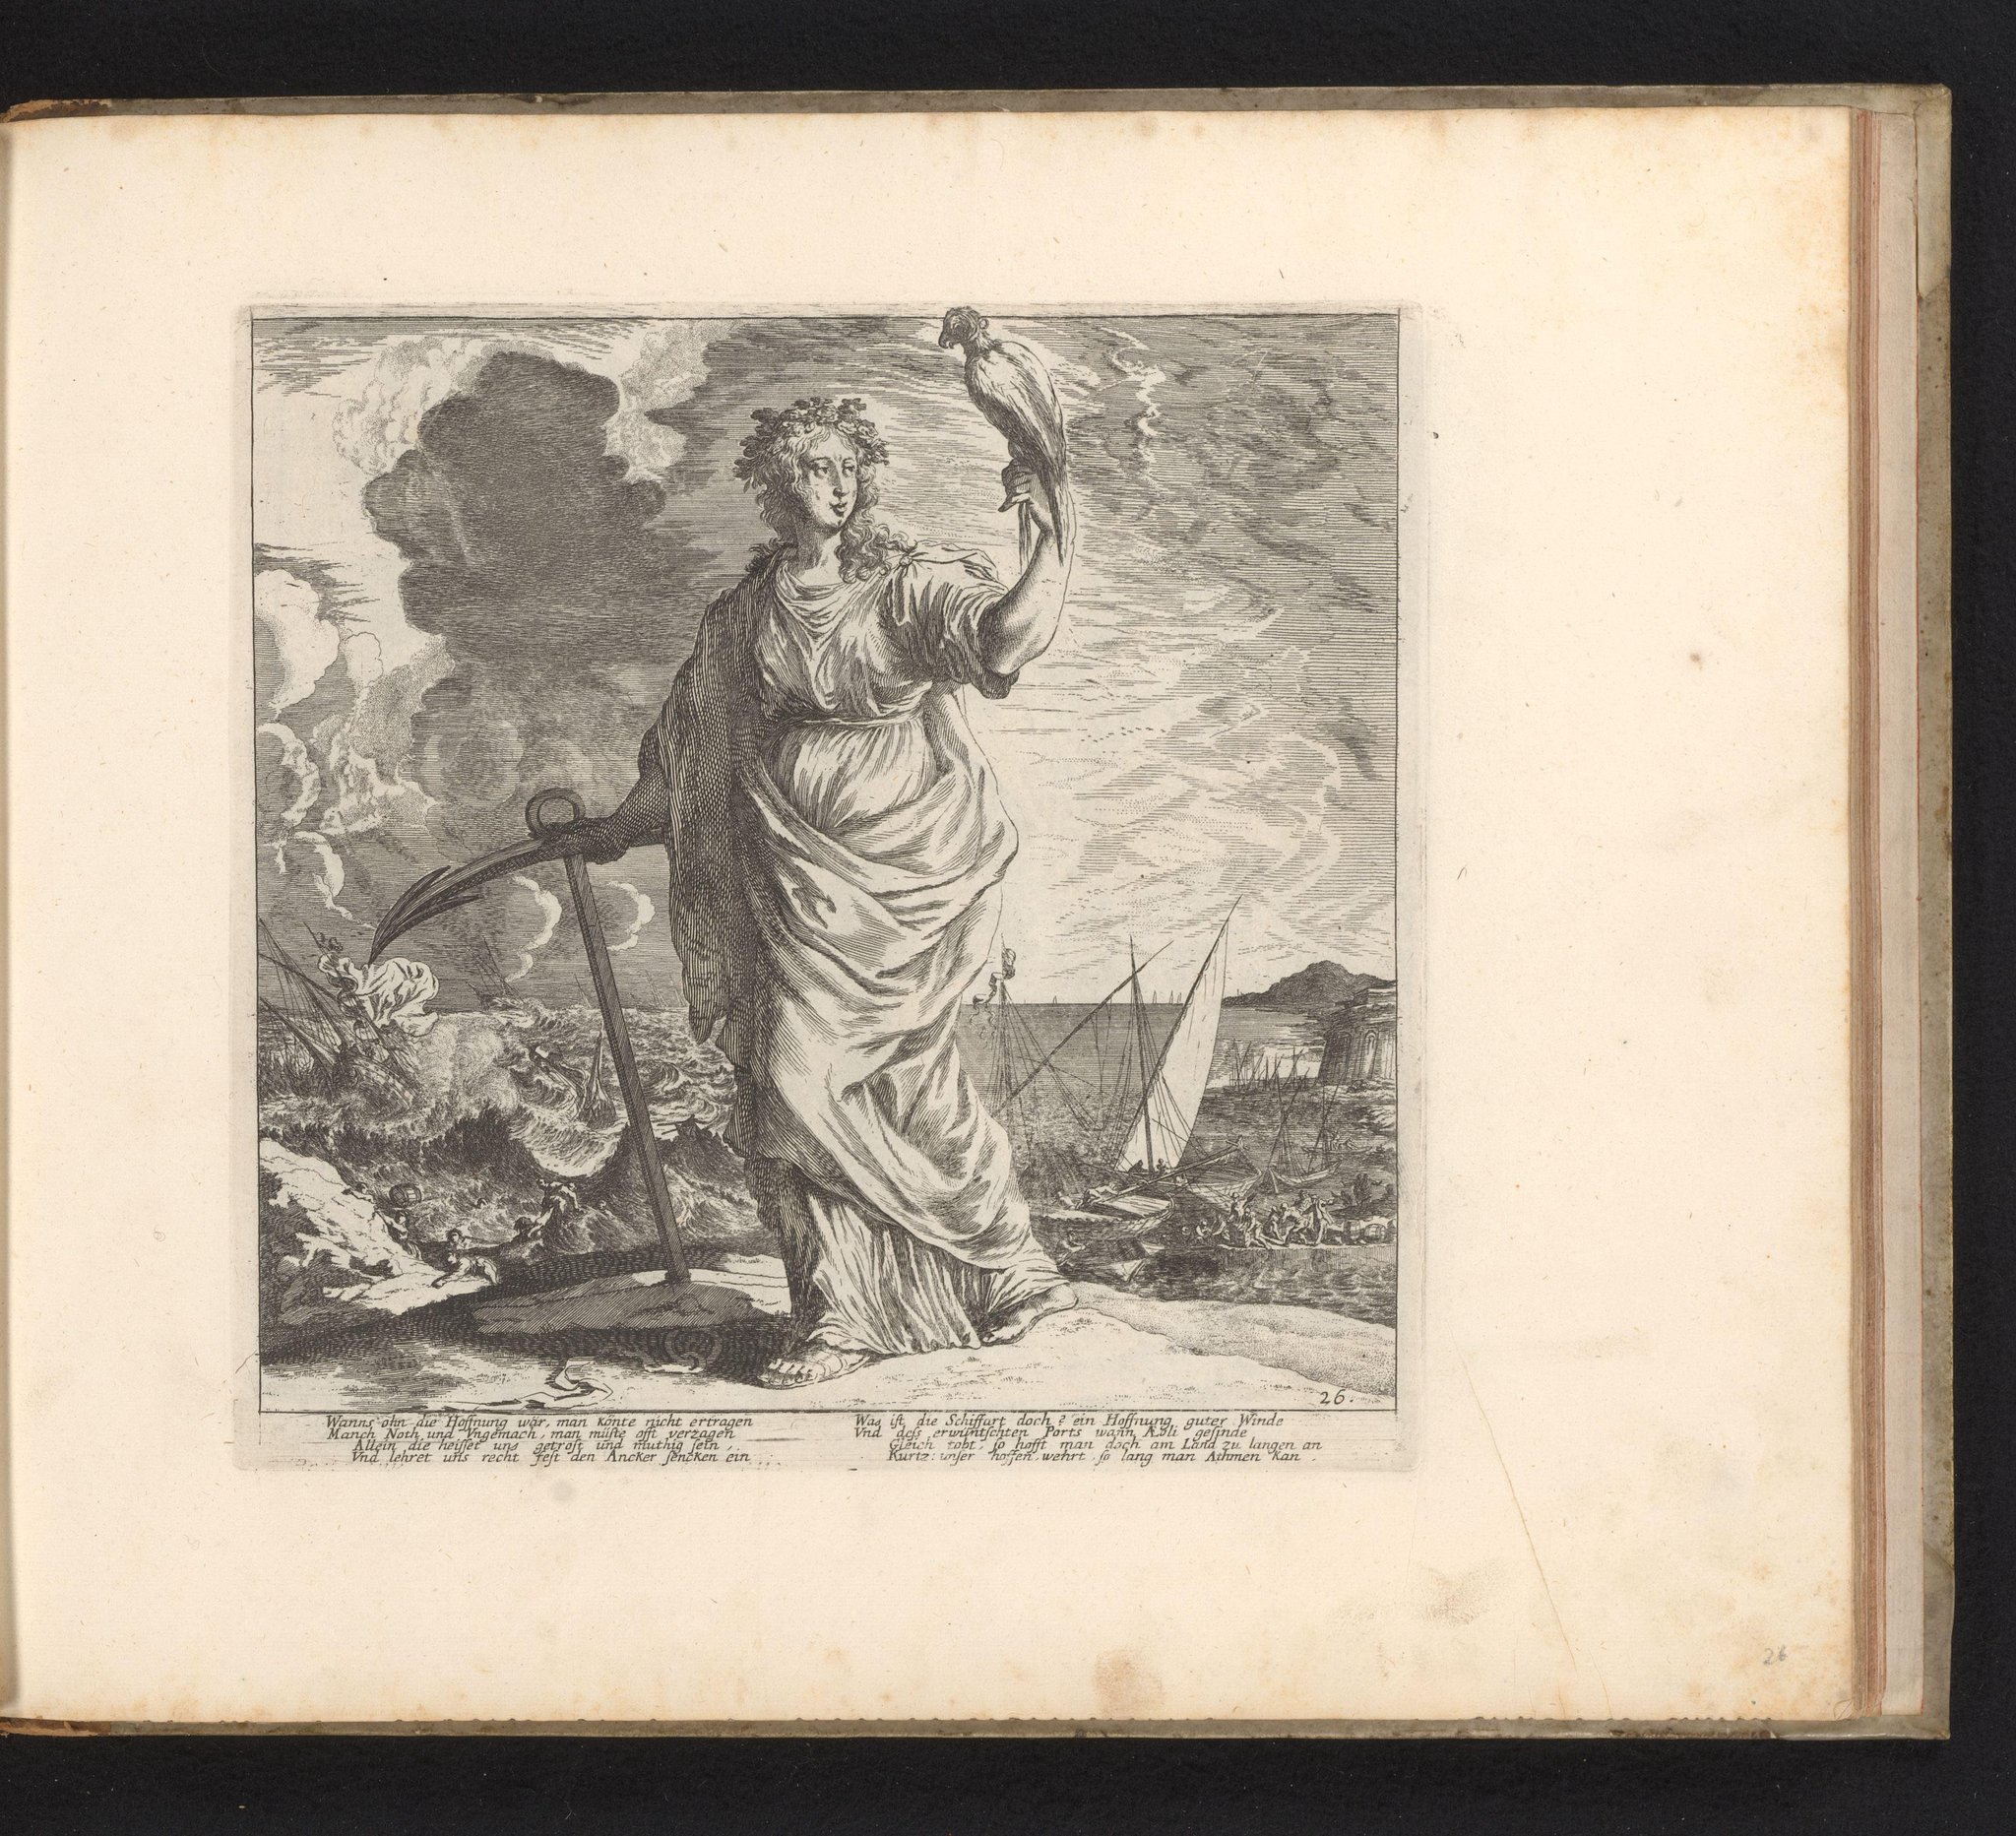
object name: print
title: Personificatie van Hoop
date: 1670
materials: paper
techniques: etching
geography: augsburg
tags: hope, 'spes'; 'speranza divina e certa' (ripa) ~ one of the three theological virtues, hope; 'speranza', 'speranza delle fatiche' (ripa)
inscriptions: collector's mark: Lugt 2228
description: Een vrouw houdt een anker vast en heeft een vogel in haar andere hand. Achter haar schepen in zwaar weer. Mogelijk ook de personificatie van zeevaart. Tekst in het Duits in de ondermarge. Rechtsonder genummerd: 26. Prent maakt deel uit van een album.